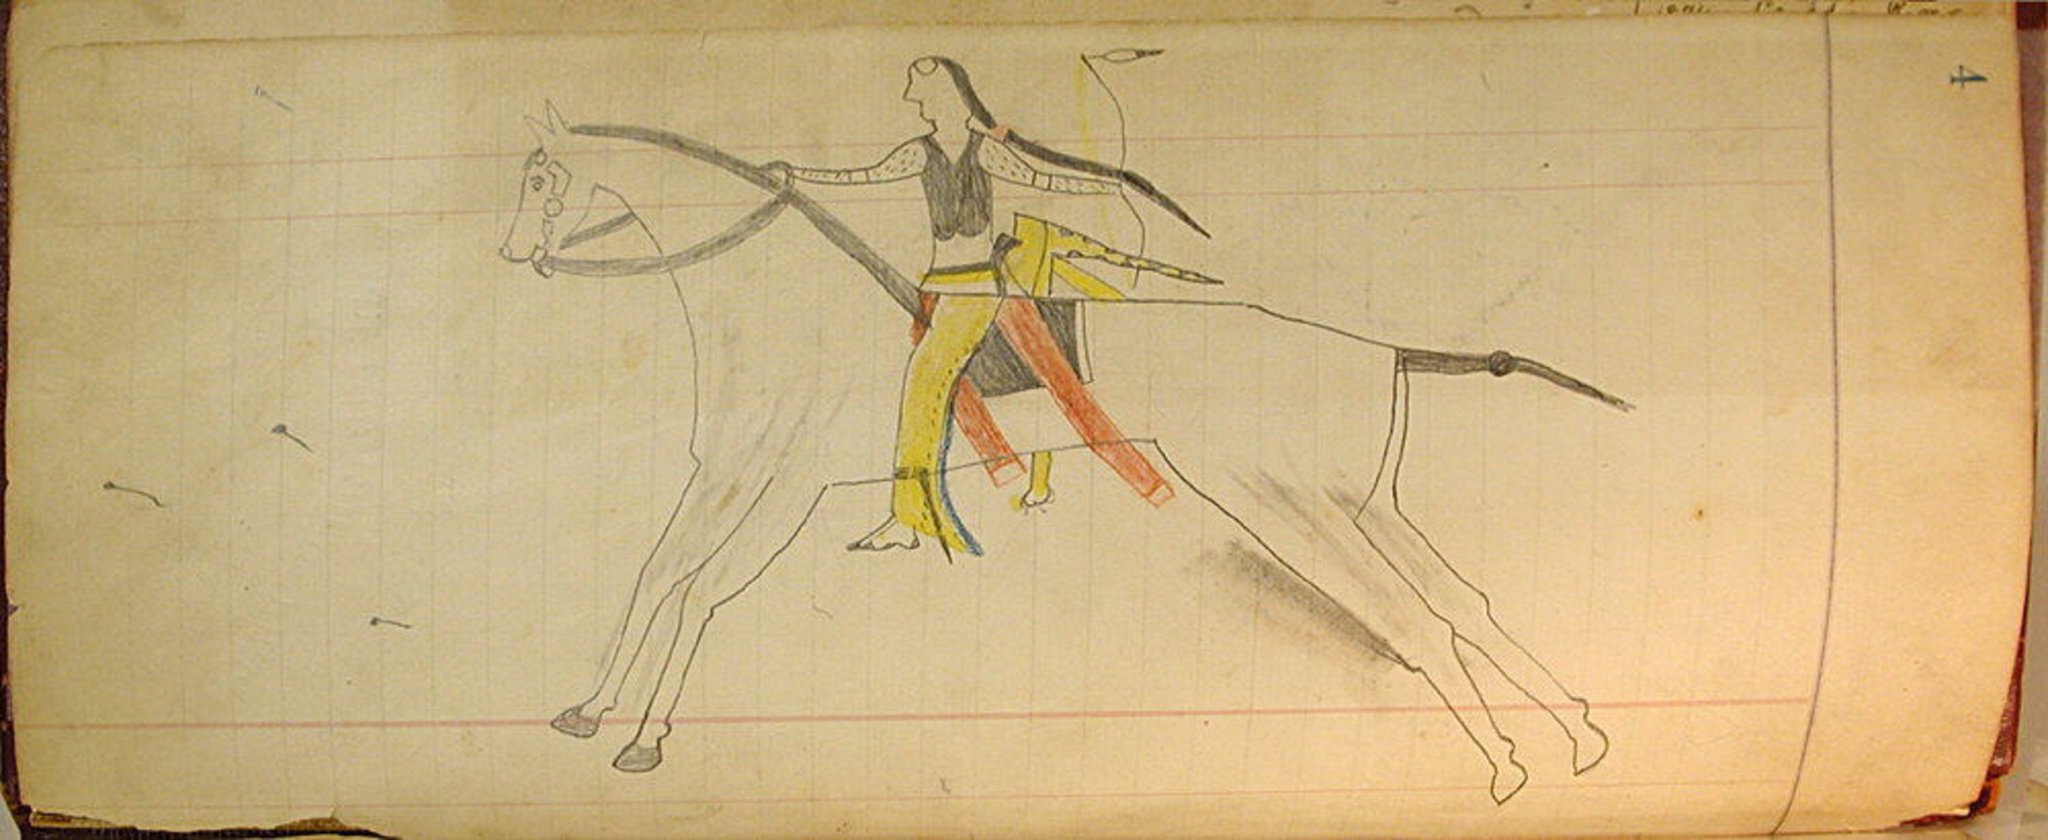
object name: drawing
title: Maffet Ledger: Mounted Indian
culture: cheyenne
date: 1874-1881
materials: crayon, graphite, paper, watercolor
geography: united states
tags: men,horses